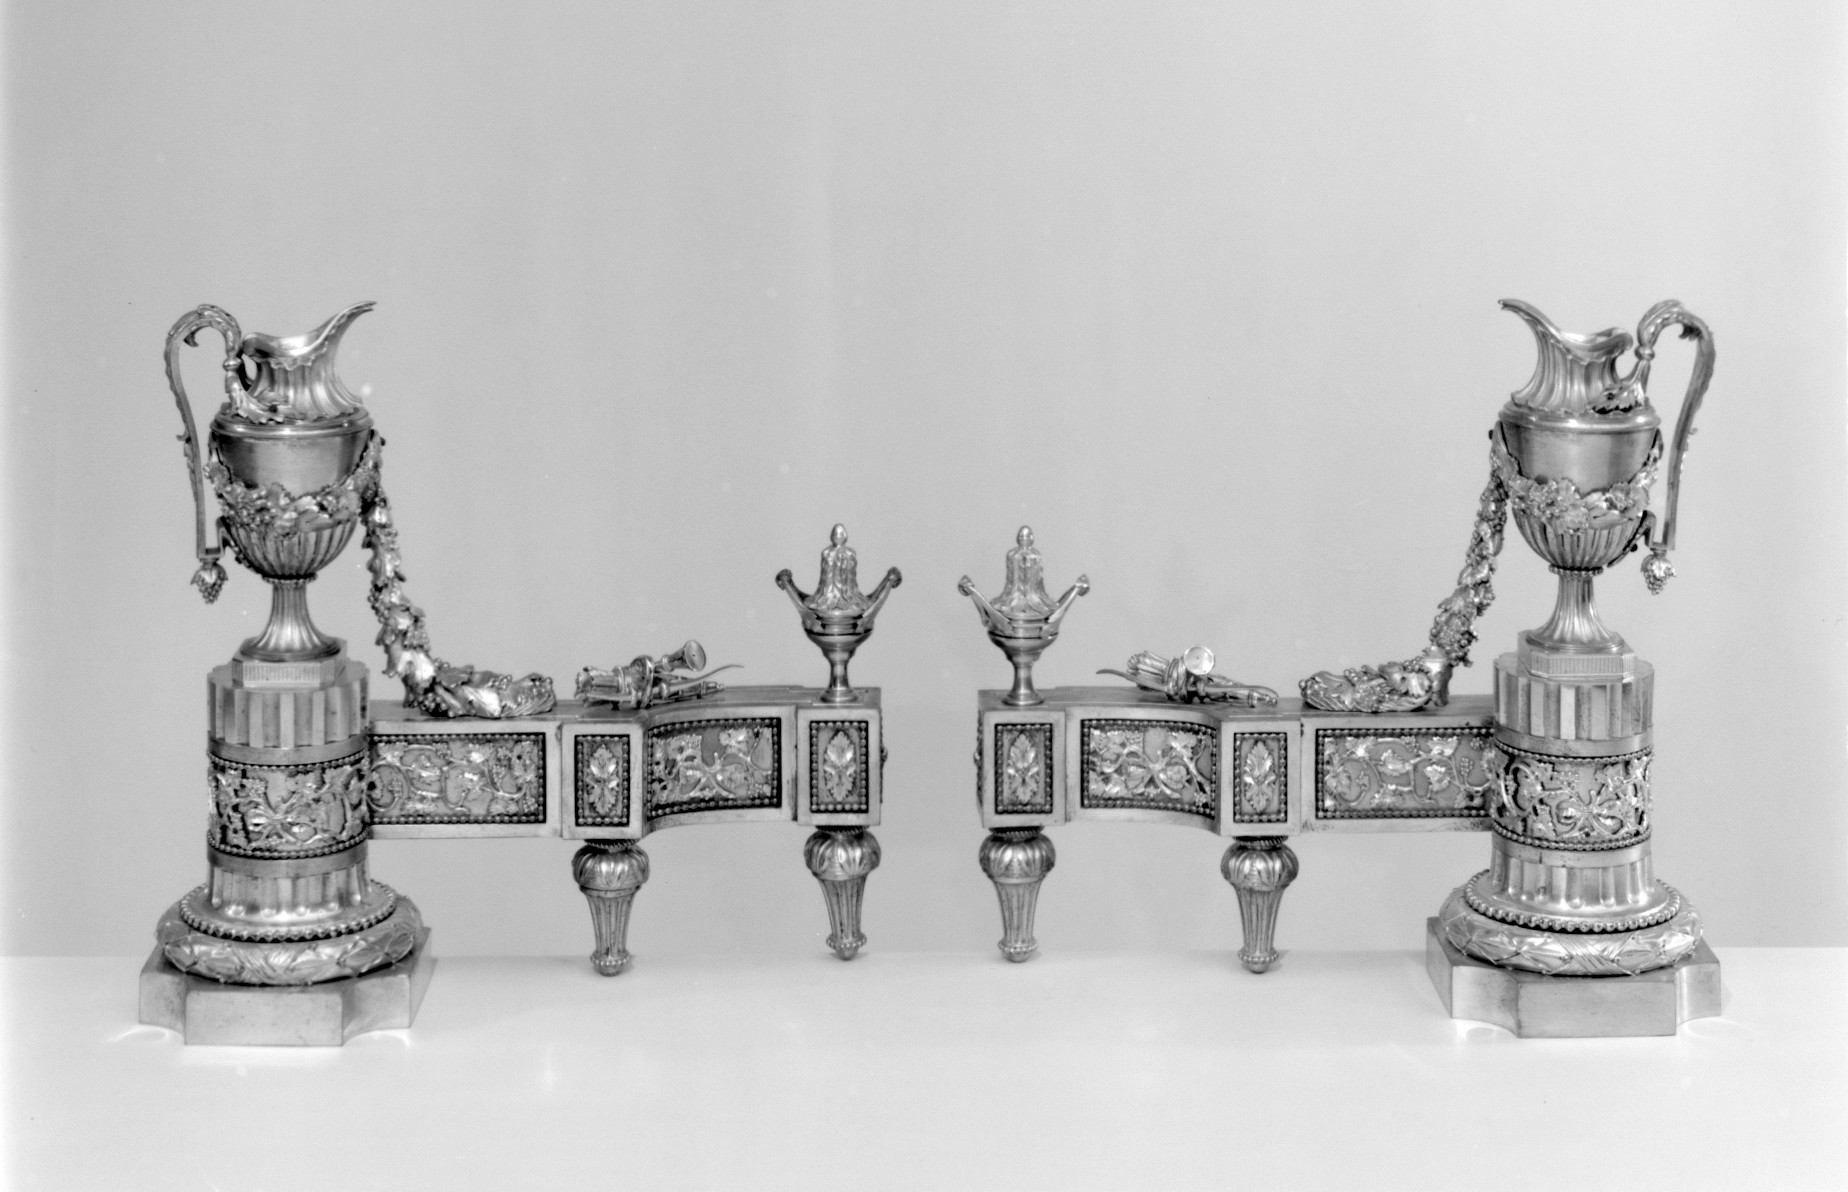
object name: andiron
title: Pair of andirons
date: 1785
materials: gilt bronze